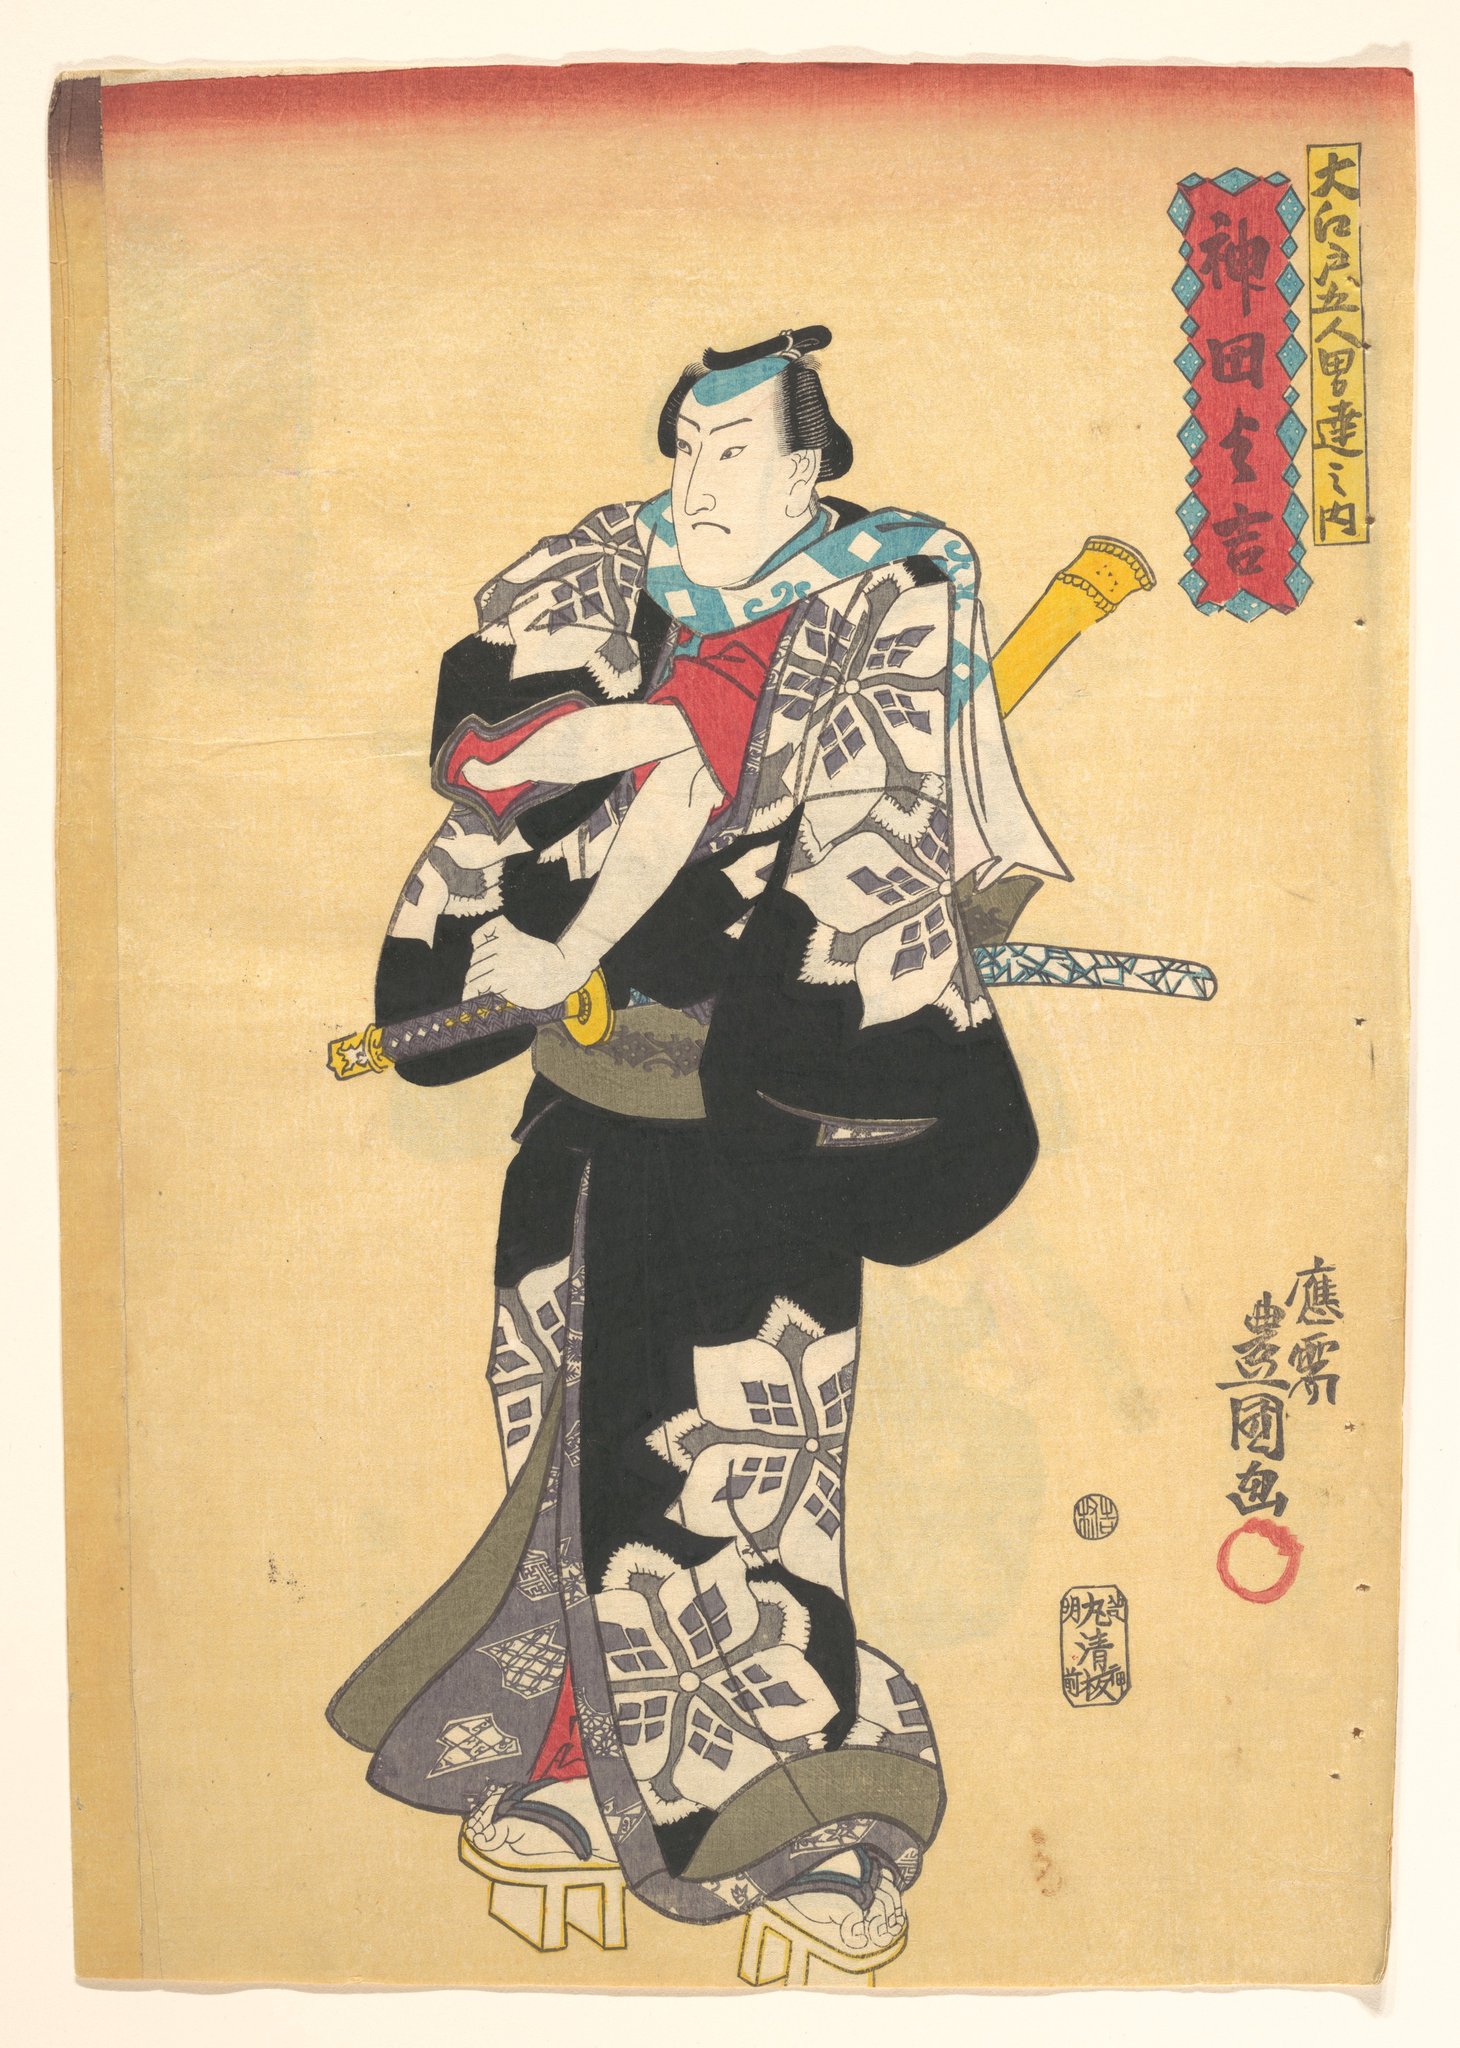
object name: print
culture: japanese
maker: utagawa kunisada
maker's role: artist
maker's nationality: japanese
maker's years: 1786-1864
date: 1801-1900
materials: ink, paper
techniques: woodblock print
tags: swords,men